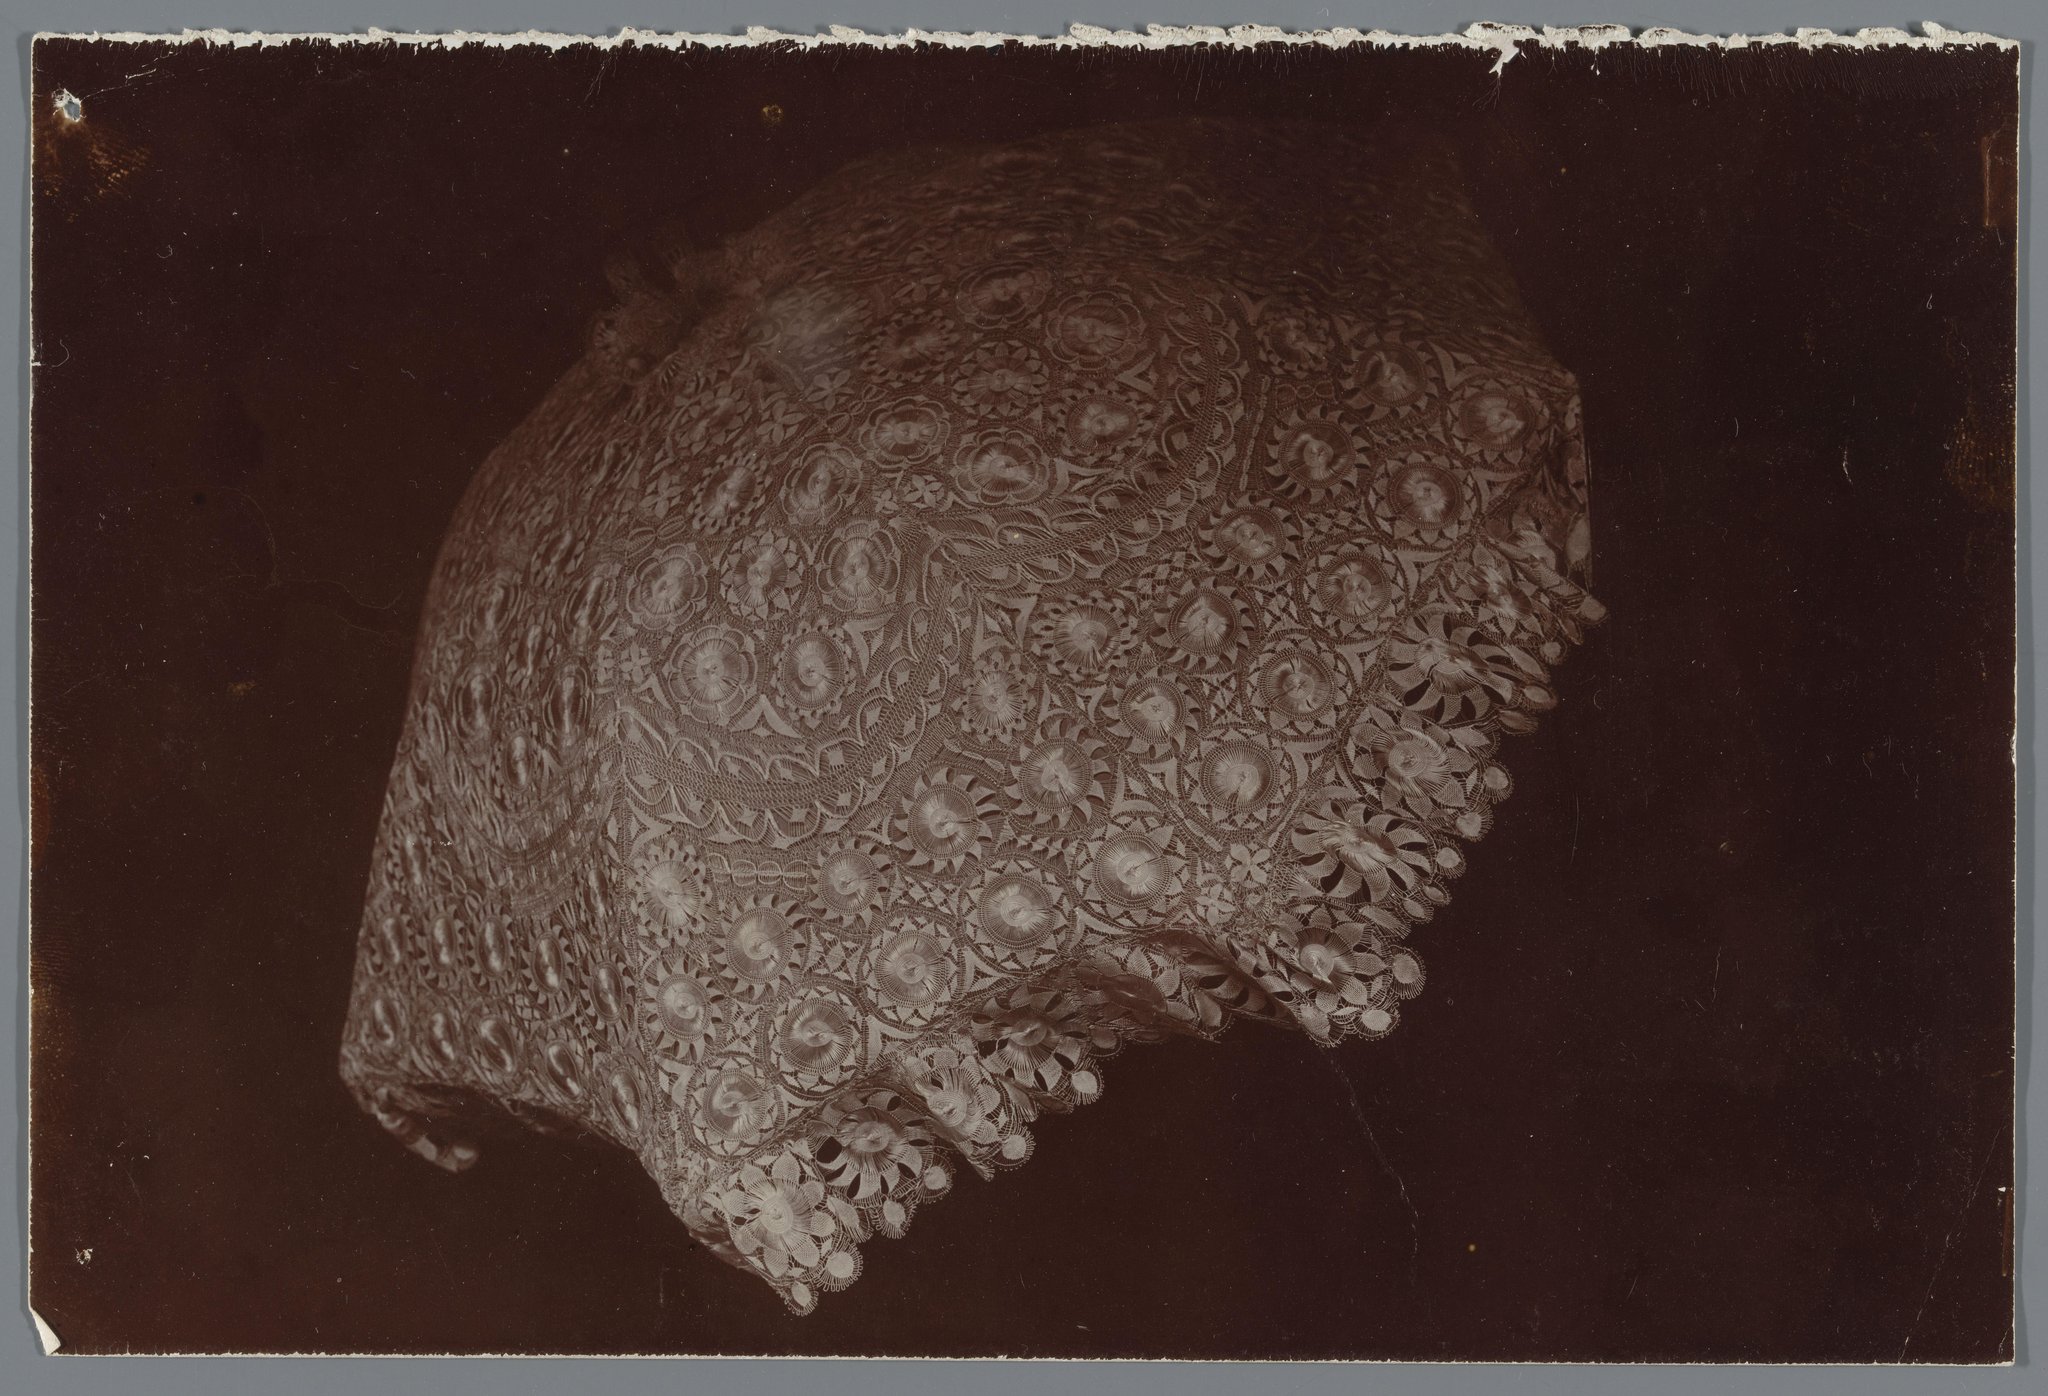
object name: photograph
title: Parasol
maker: Anonymous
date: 1890-1920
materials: paper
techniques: collodion silver print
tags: lace, parasol, sunshade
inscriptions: inscription: ‘parasol’